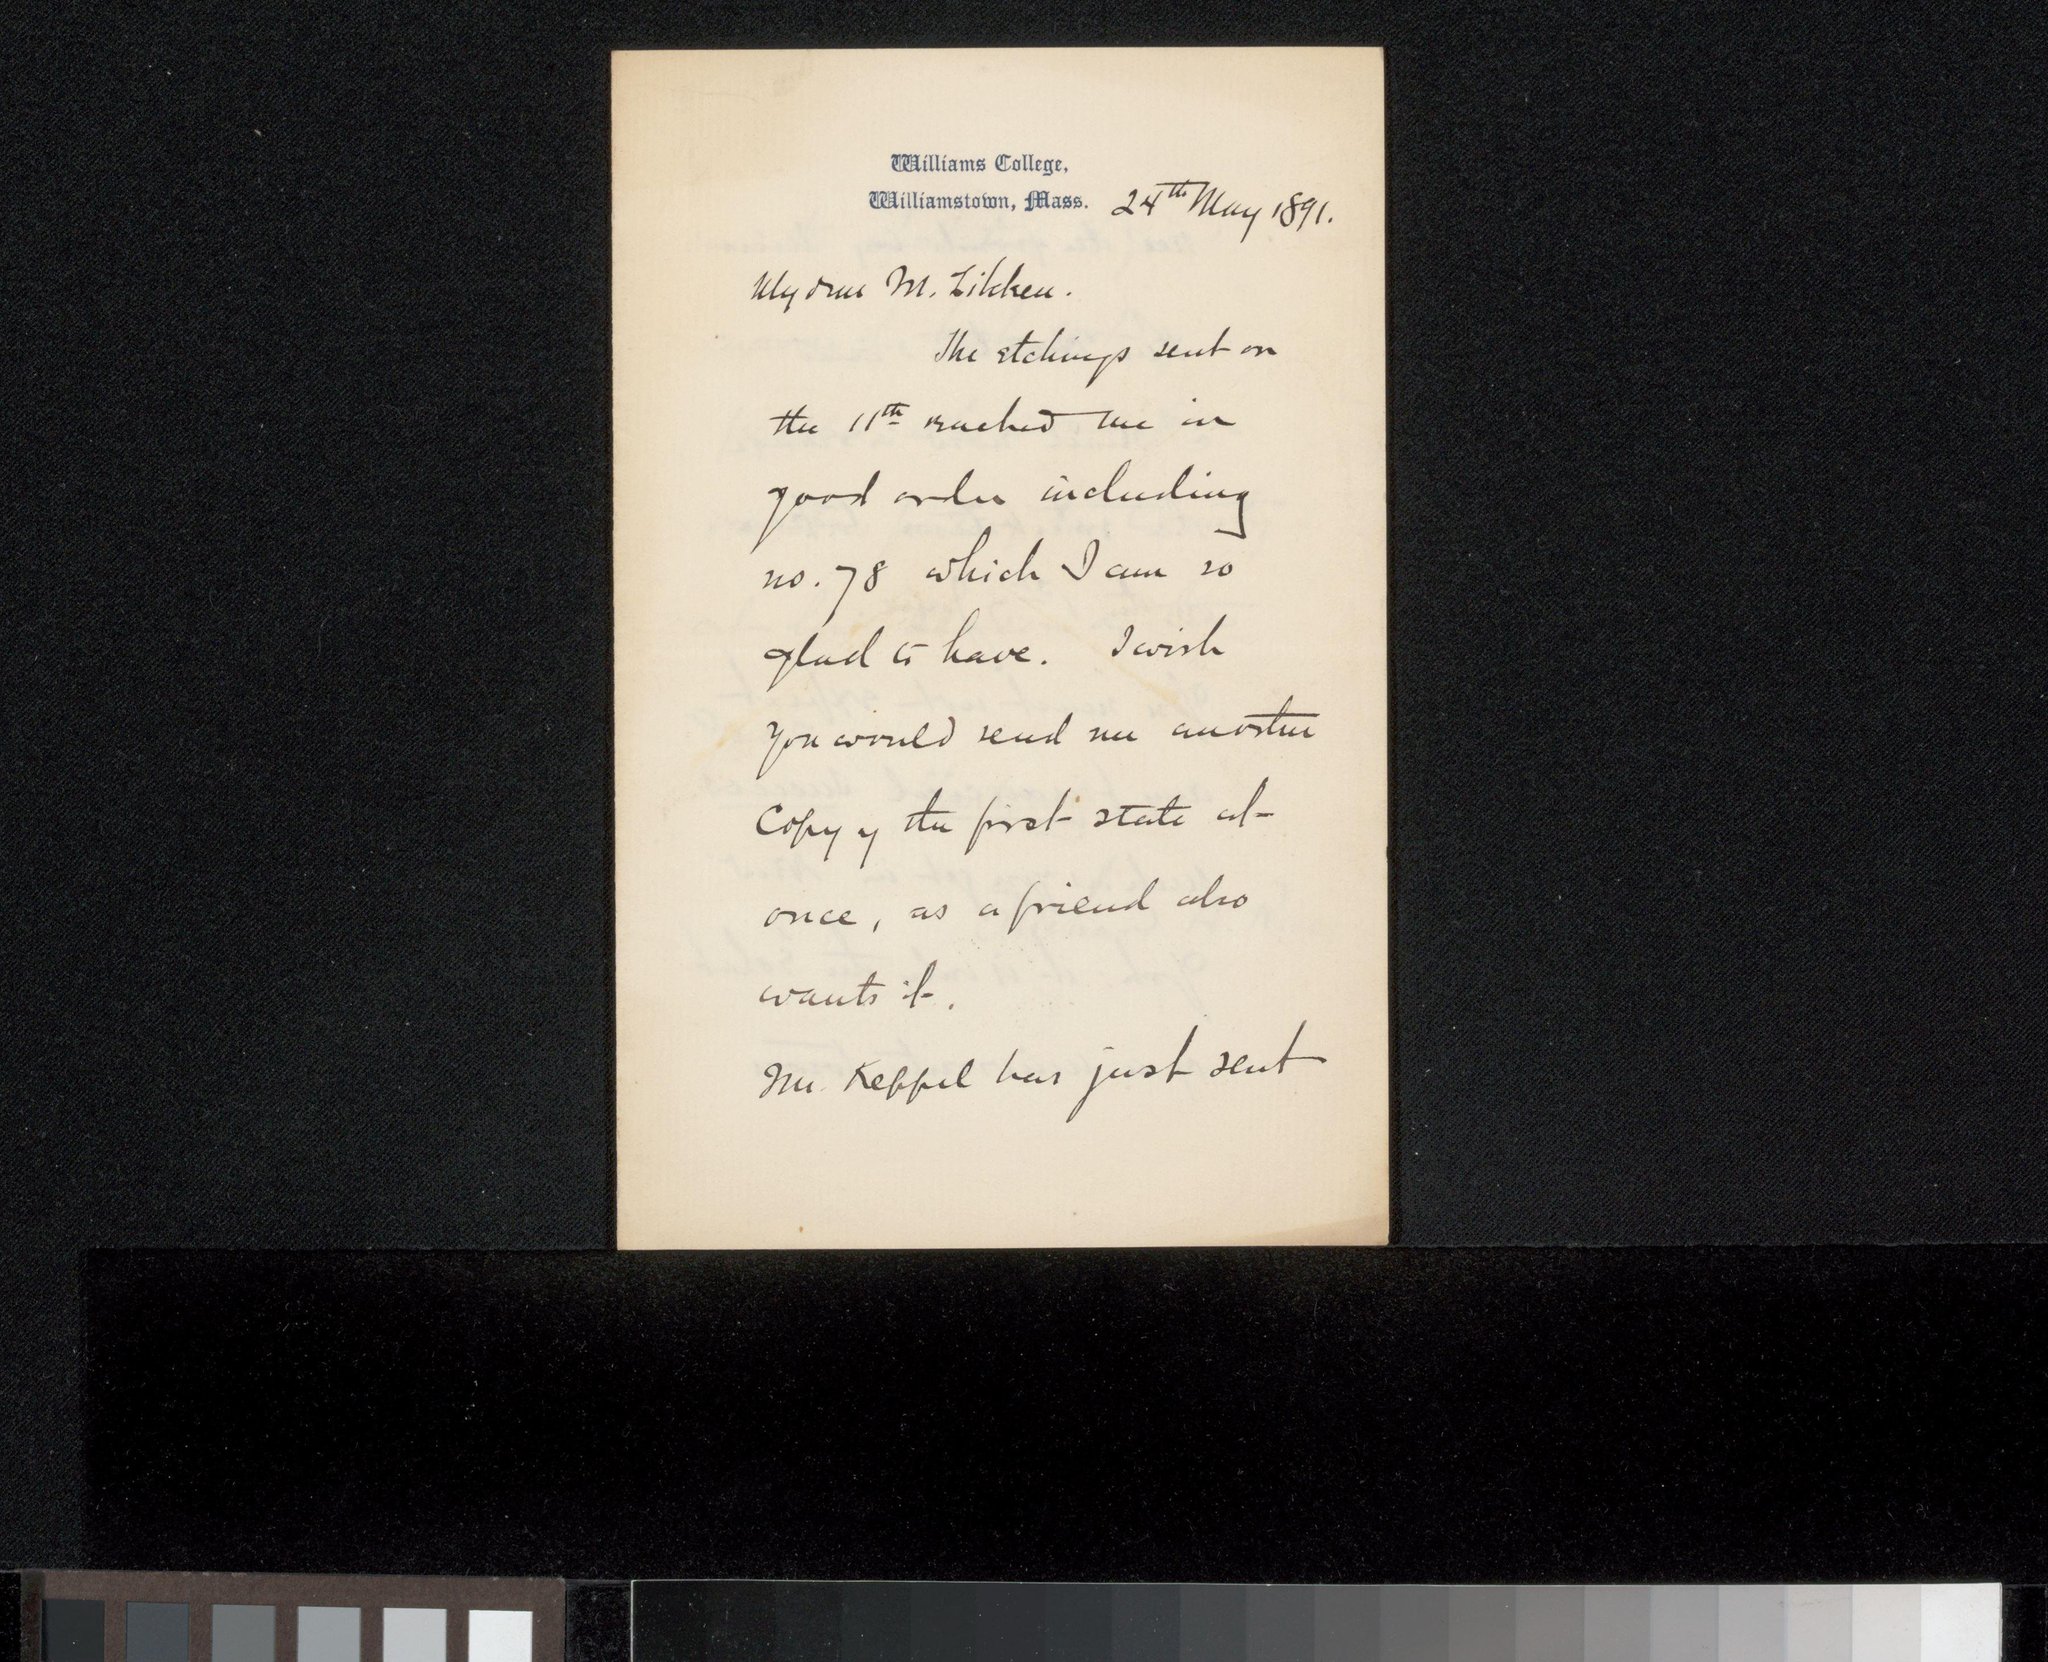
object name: letter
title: Brief aan Philip Zilcken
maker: richard austin rice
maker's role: professor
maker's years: 1846-1925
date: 1891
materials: ink, paper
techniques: pen, printing, writing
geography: williamstown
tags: print maker, marius bauer, the hague, painter, draughtsman, philip zilcken, art trade, art shop, the graphic arts, temporary exhibition, 'salon'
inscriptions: collector's mark: ‘RPK’, watermark